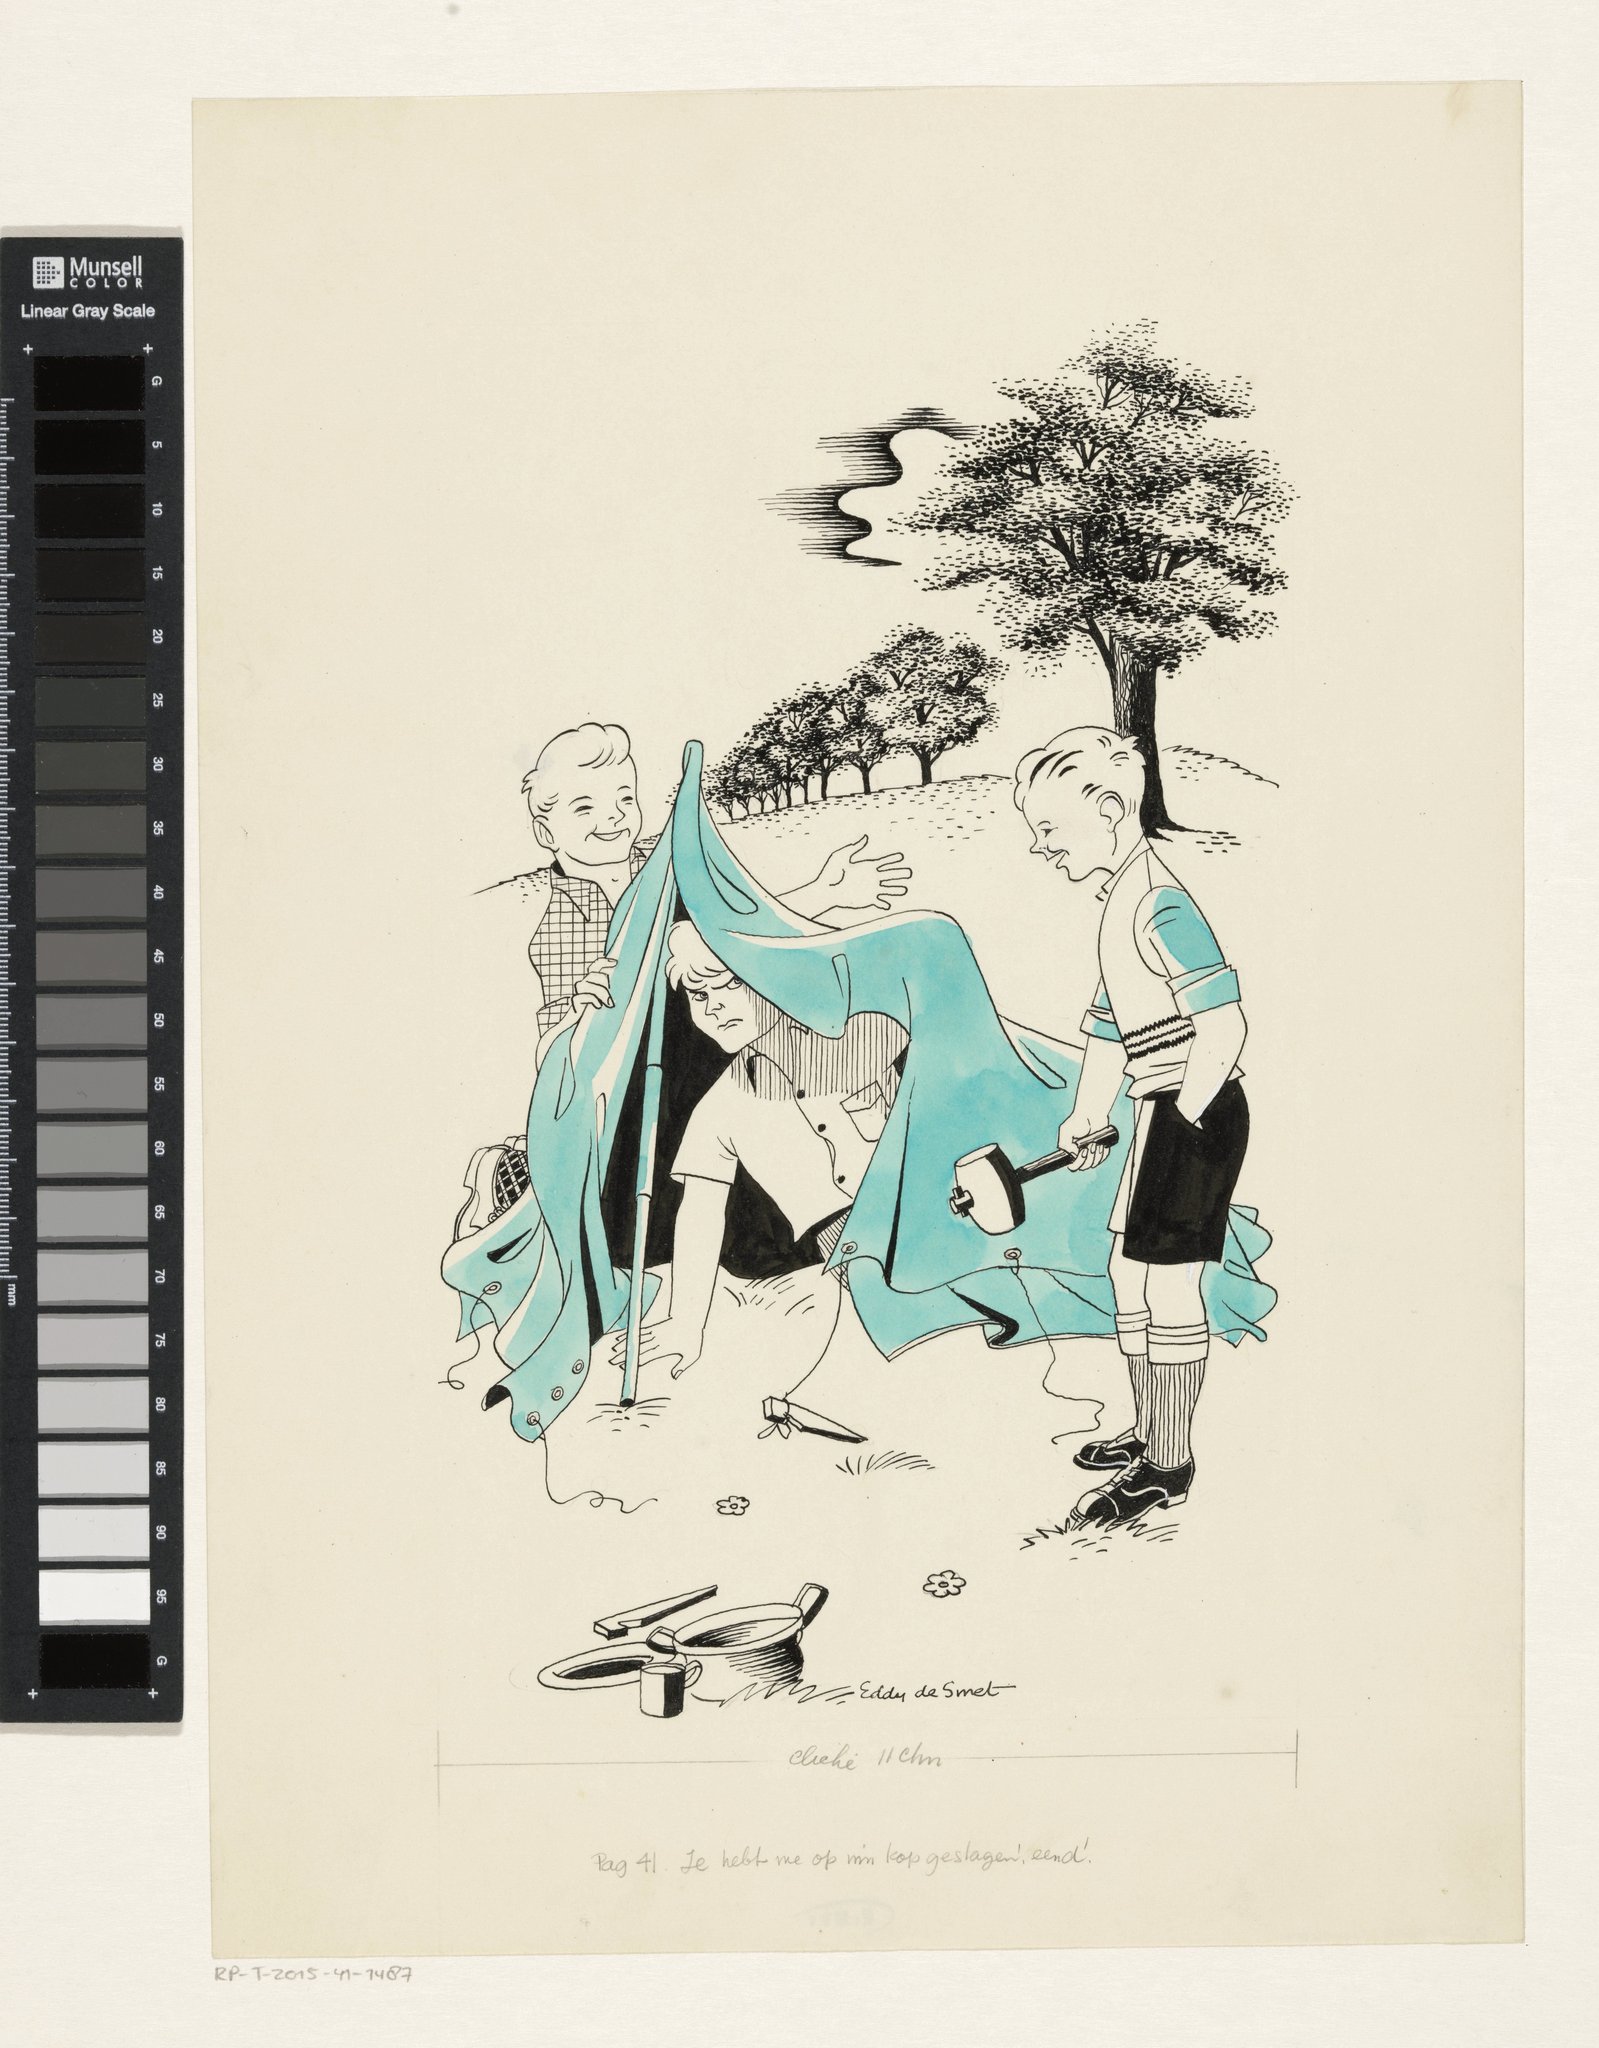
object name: drawing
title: Drie jongens zetten een tent op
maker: eddy de smet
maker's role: draughtsman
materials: paint, ink, paper, pencil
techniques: brush, pen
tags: tent, tools, aids, implements ~ crafts and industries: hammer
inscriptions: annotation: ‘Pag 41 Je hebt me op m'n kop geslagen! eend!’, :, collector's mark: Lugt 2228, signature: ‘Eddy de Smet’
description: Op een veld proberen drie jongens een tent op te zetten. Eén jongen zit onder het doek en twee staan ernaast. Eén van hen heeft een hamer in de hand en lacht.